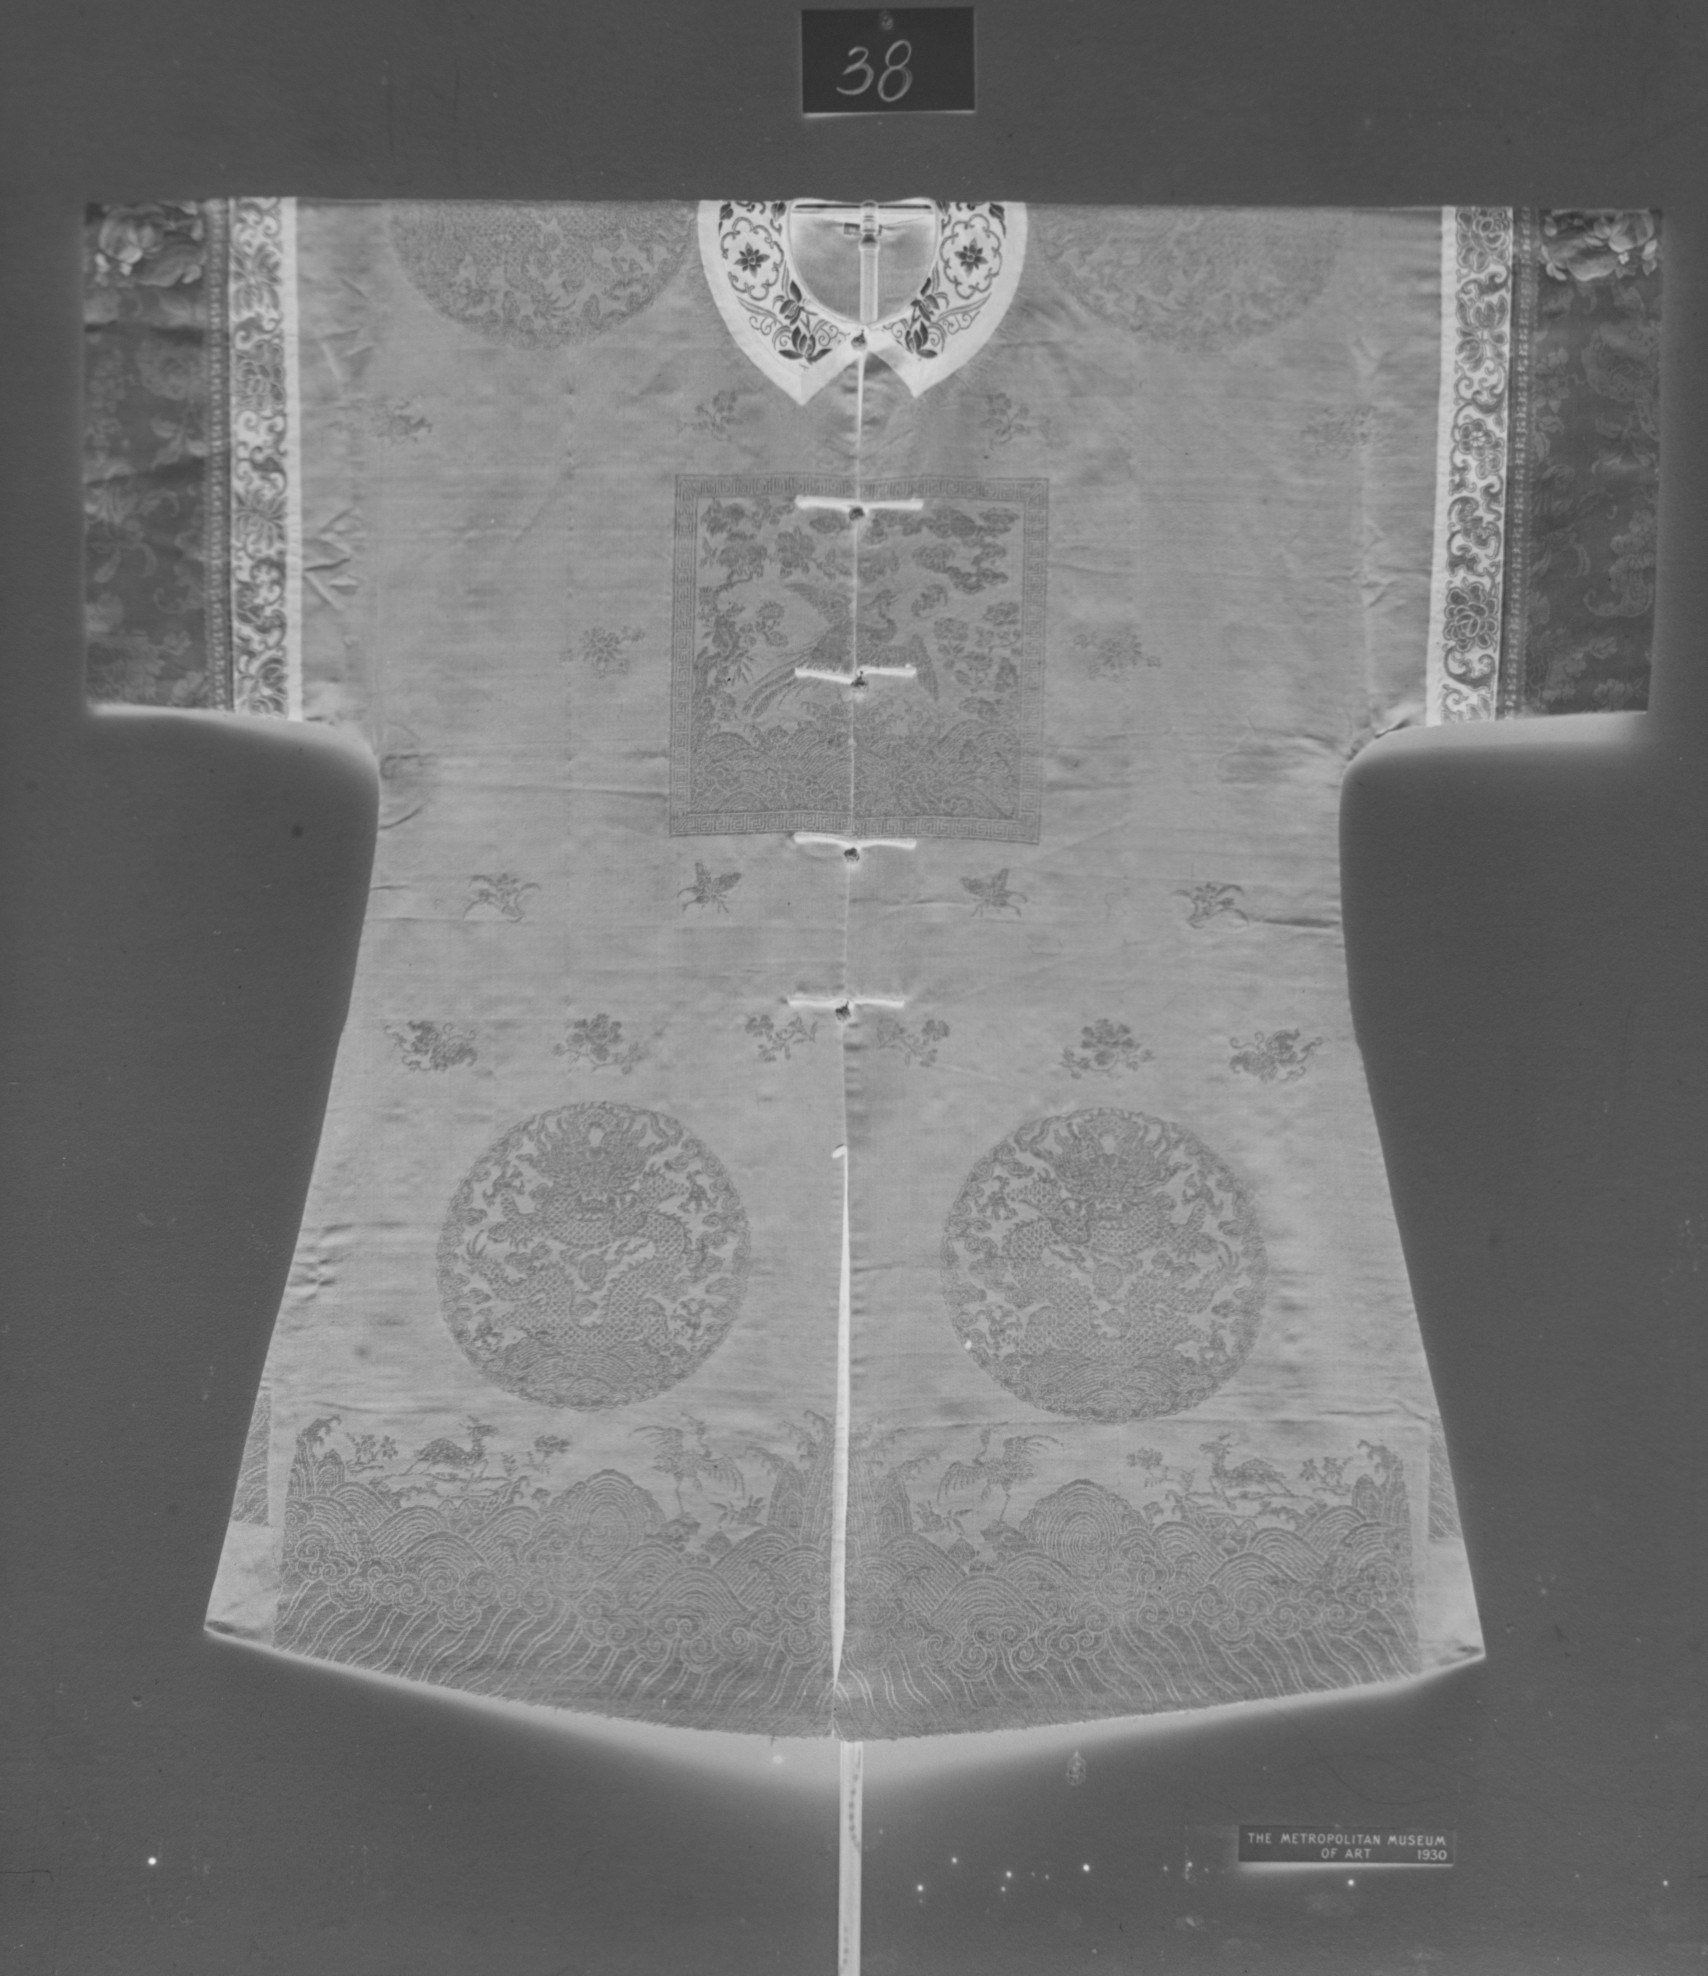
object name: coat, ceremonial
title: Ceremonial Coat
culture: chinese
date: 1801-1900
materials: metal thread, silk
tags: animals,birds,dragons